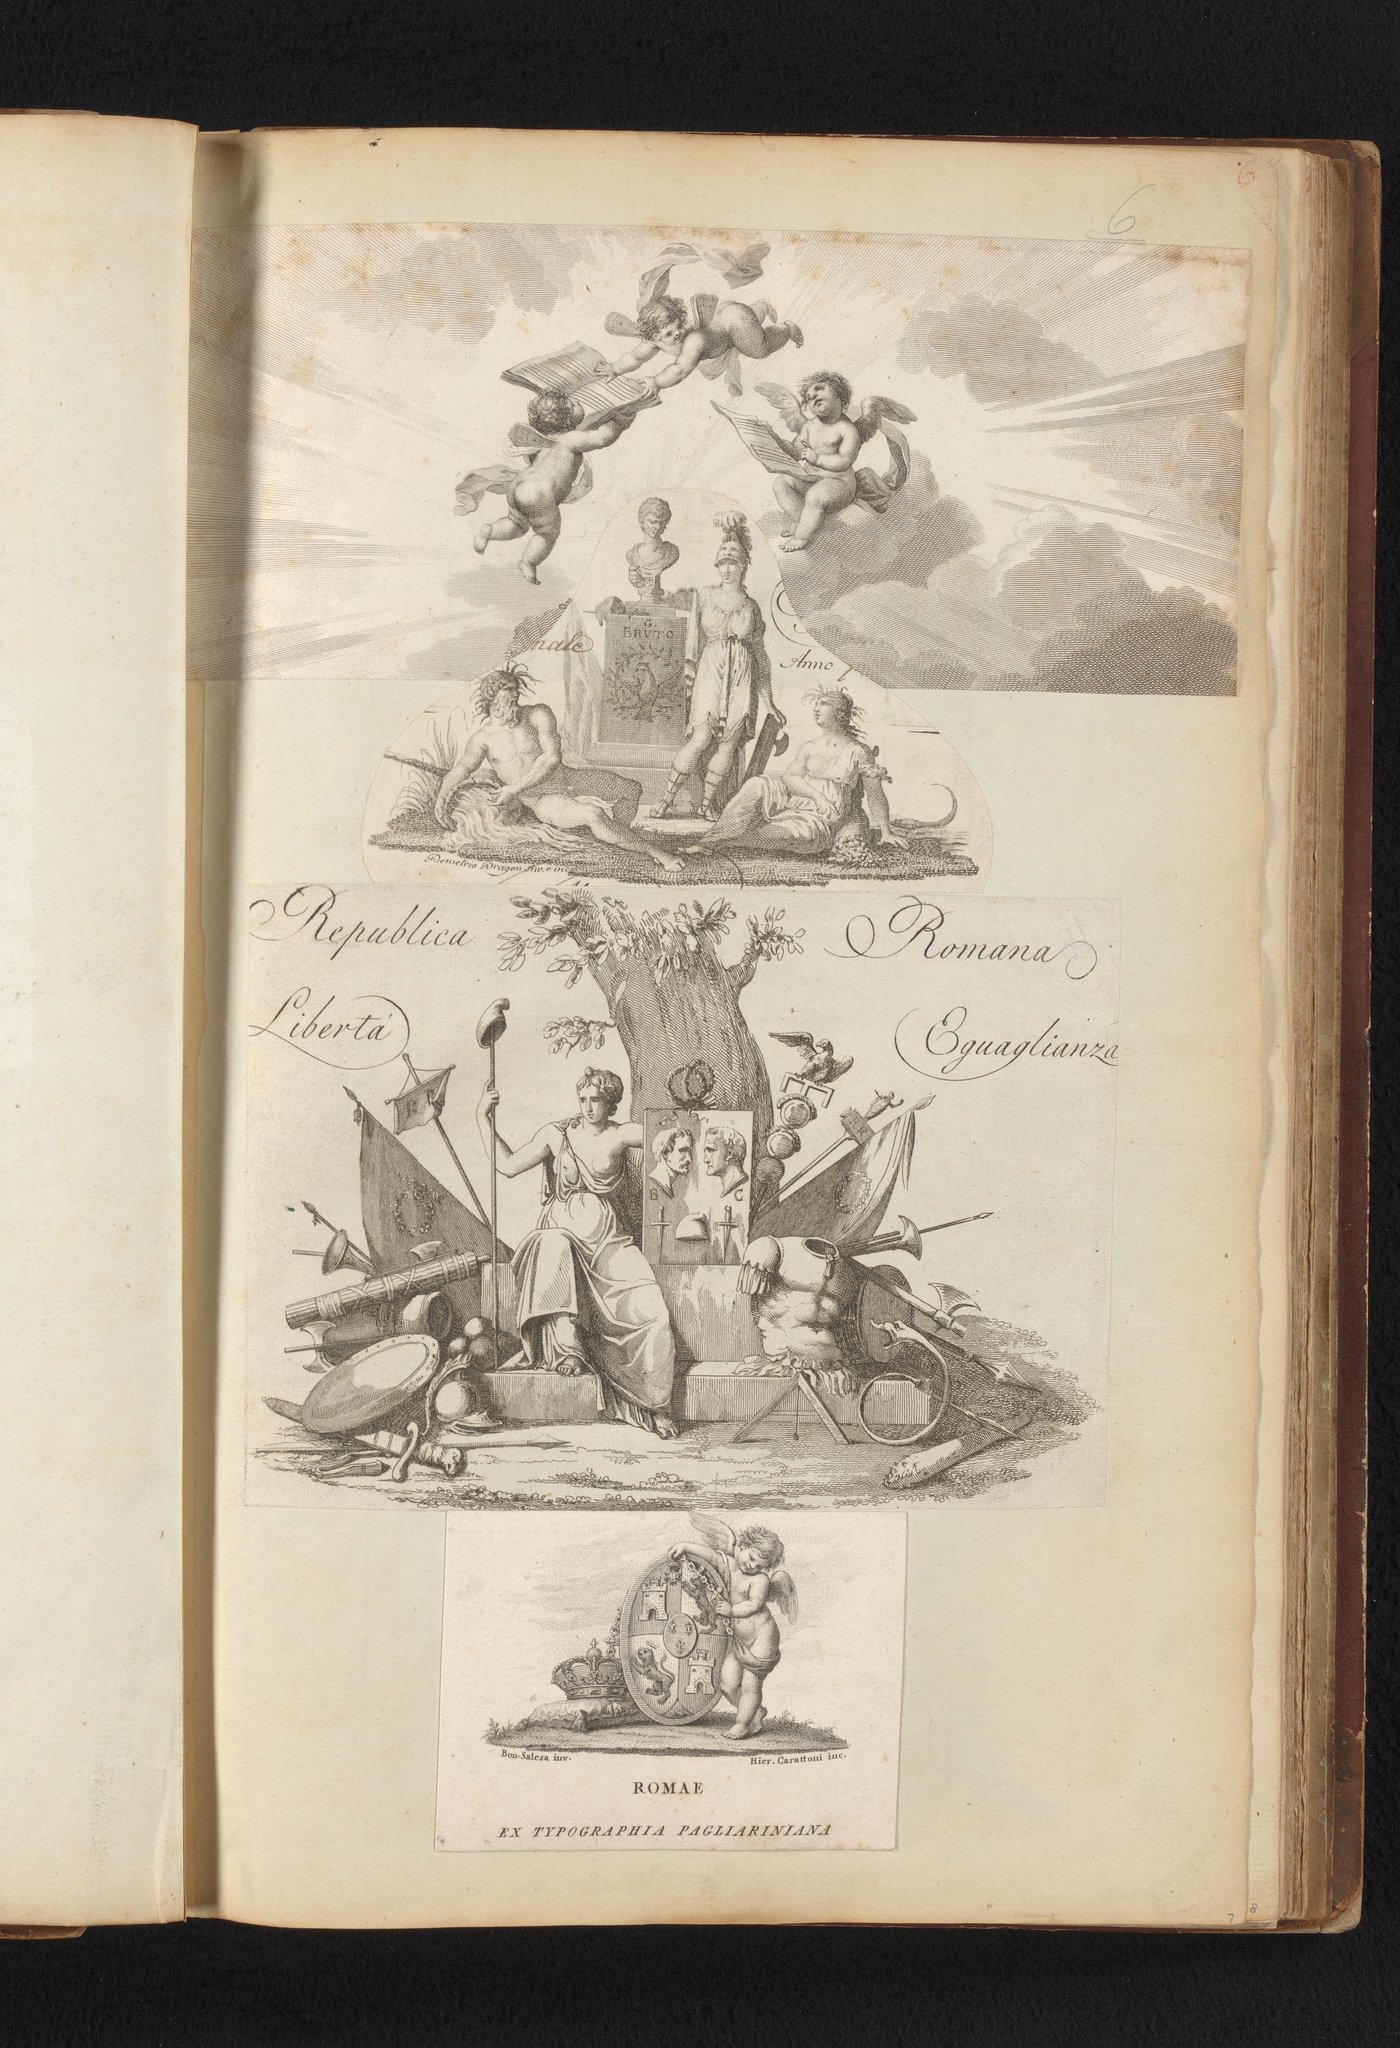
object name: collage visual work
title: Allegorische Romeinse vignetten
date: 1750-1816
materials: paper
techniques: engraving, etching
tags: rome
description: Vier allegorische vignetten gerelateerd aan Rome. De bovenste twee knipsels gecombineerd in een collage. Onderdeel van het tweede van twee albums met ingeplakte prenten en tekeningen te dienen als tekenvoorbeelden.